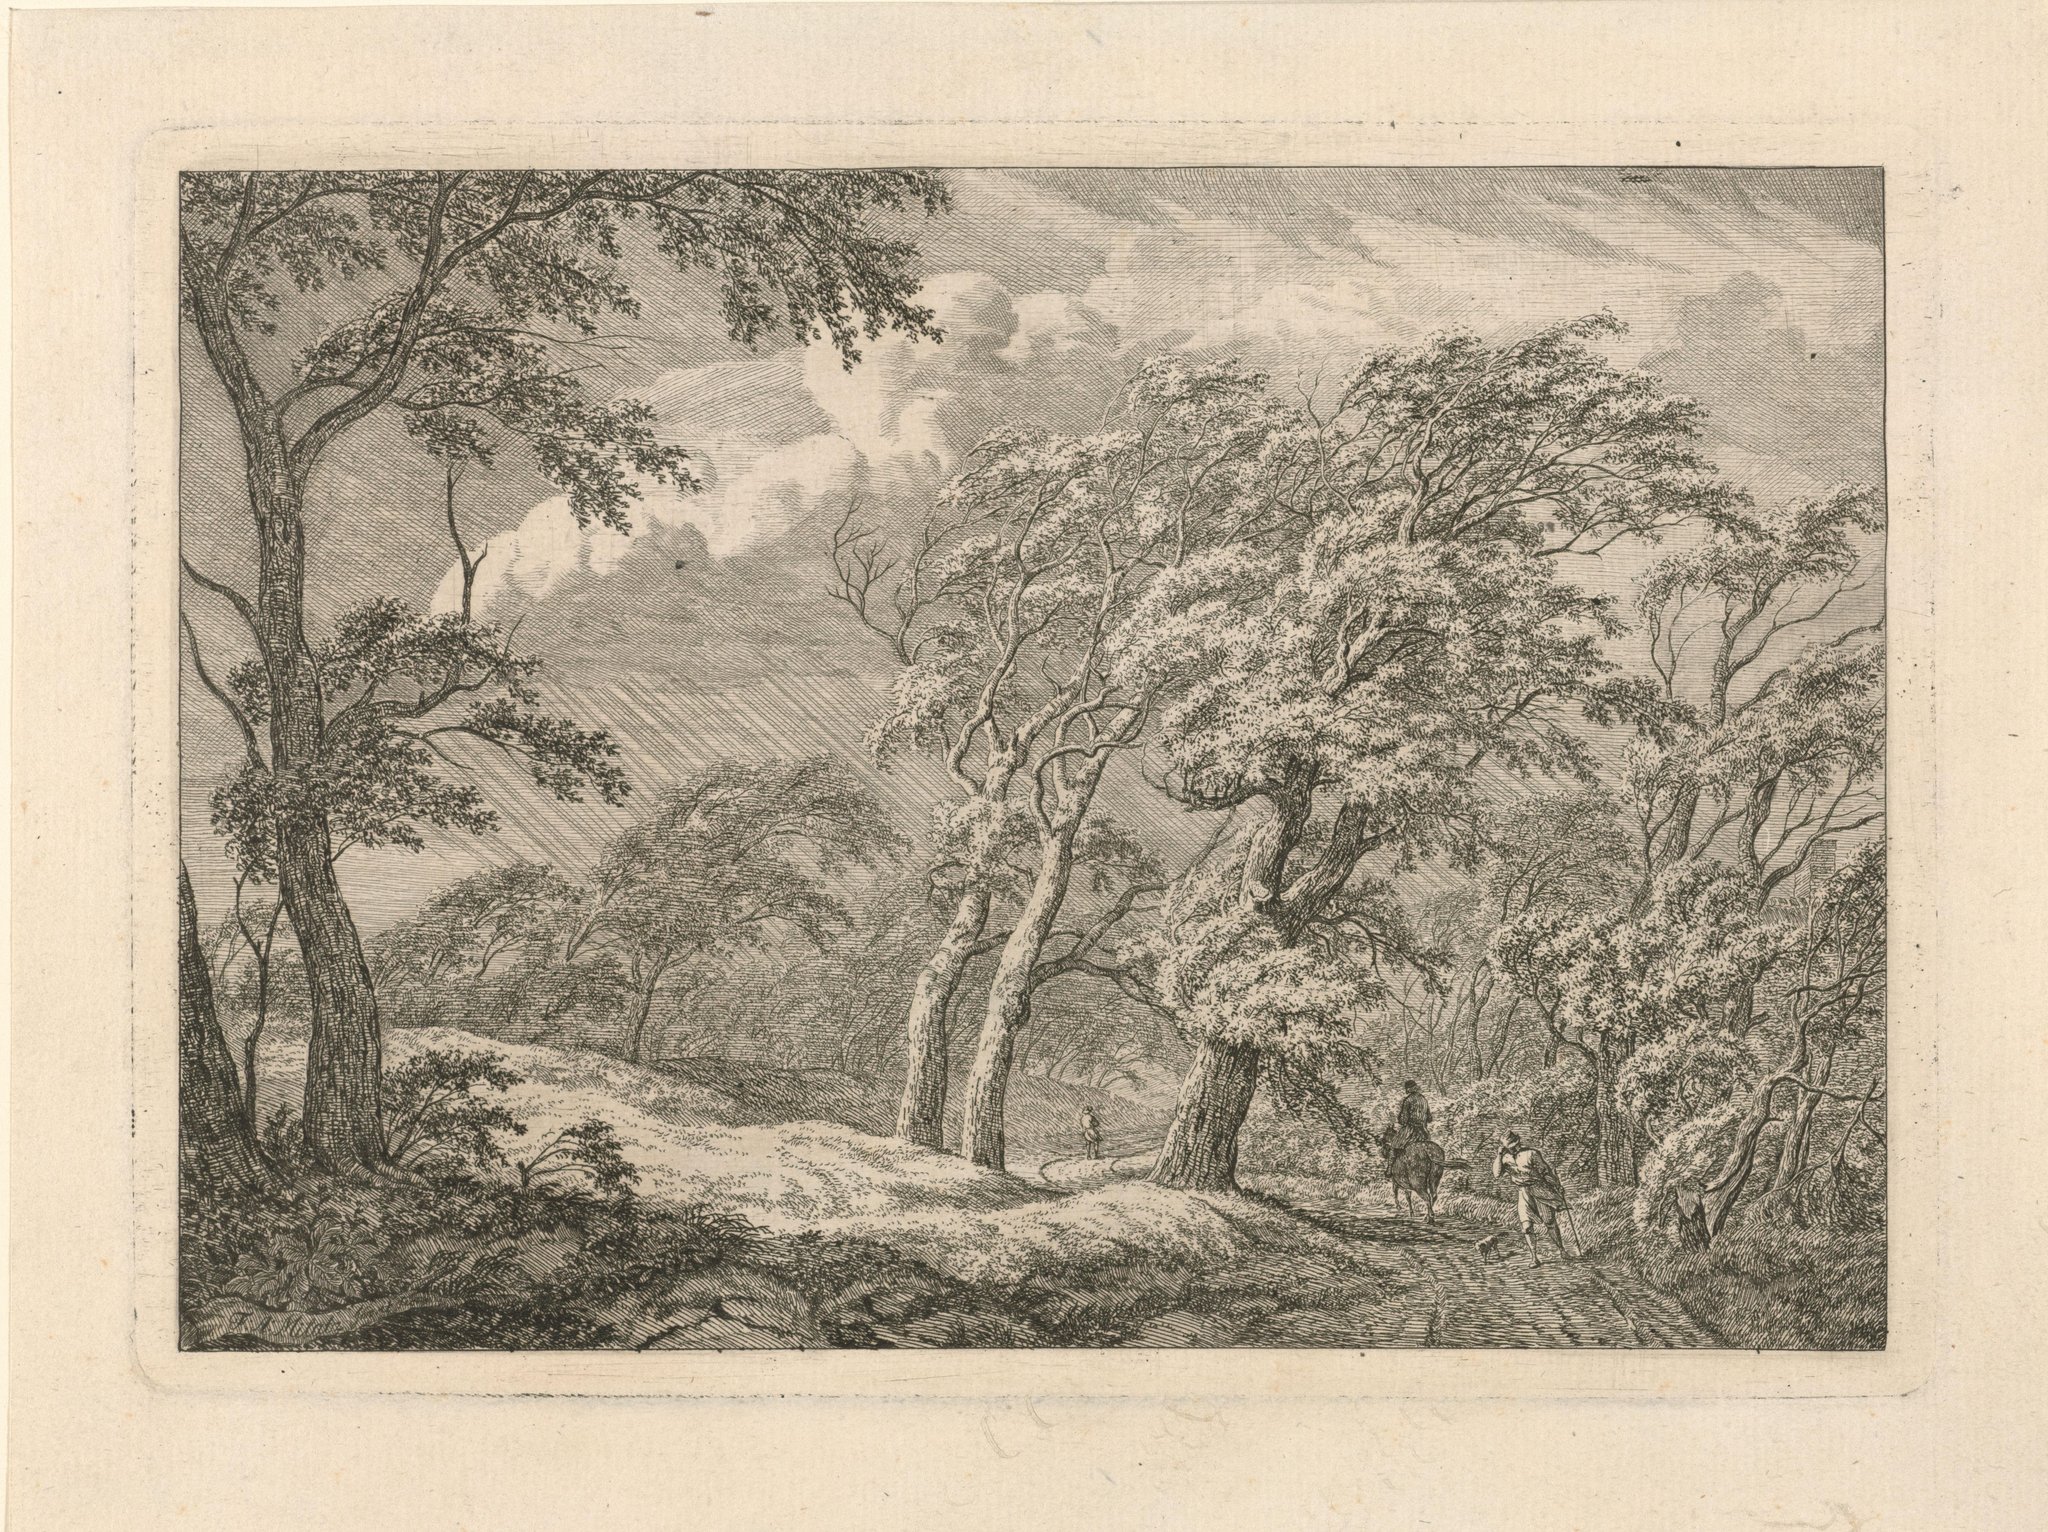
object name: print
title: Landschap met storm en regen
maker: franciscus andreas milatz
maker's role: draughtsman, painter, print maker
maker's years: 1764-1808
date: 1784-1808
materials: paper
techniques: etching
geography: haarlem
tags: trees, rain, 'en route', traveller under way, storm on land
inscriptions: collector's mark: Lugt 2228, collector's mark: Lugt 2760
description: Een duinlandschap met door de storm gebogen bomen en regen. Rechts een ruiter en een man met een hond op de weg.